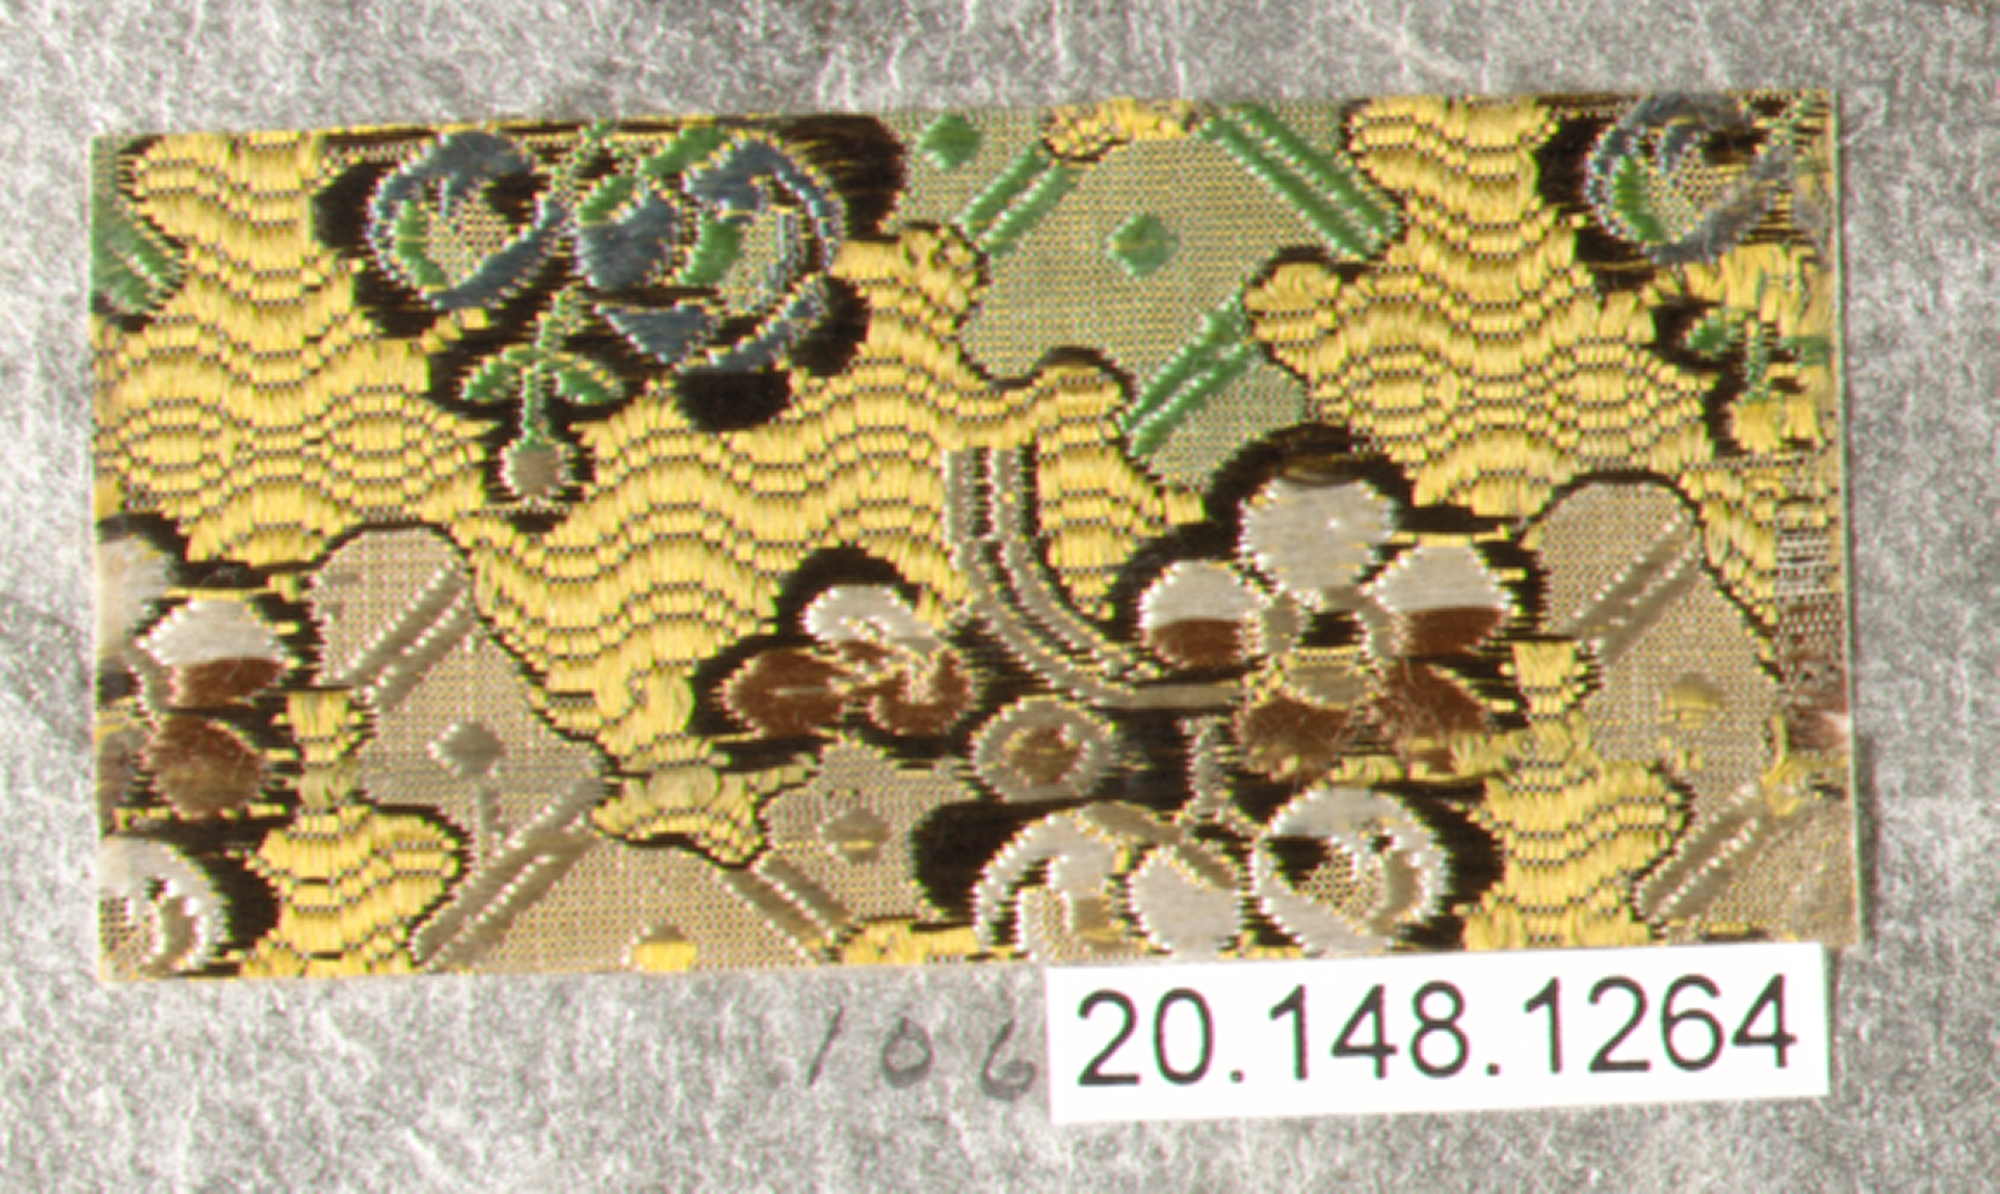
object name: piece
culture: chinese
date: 1701-1800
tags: flowers